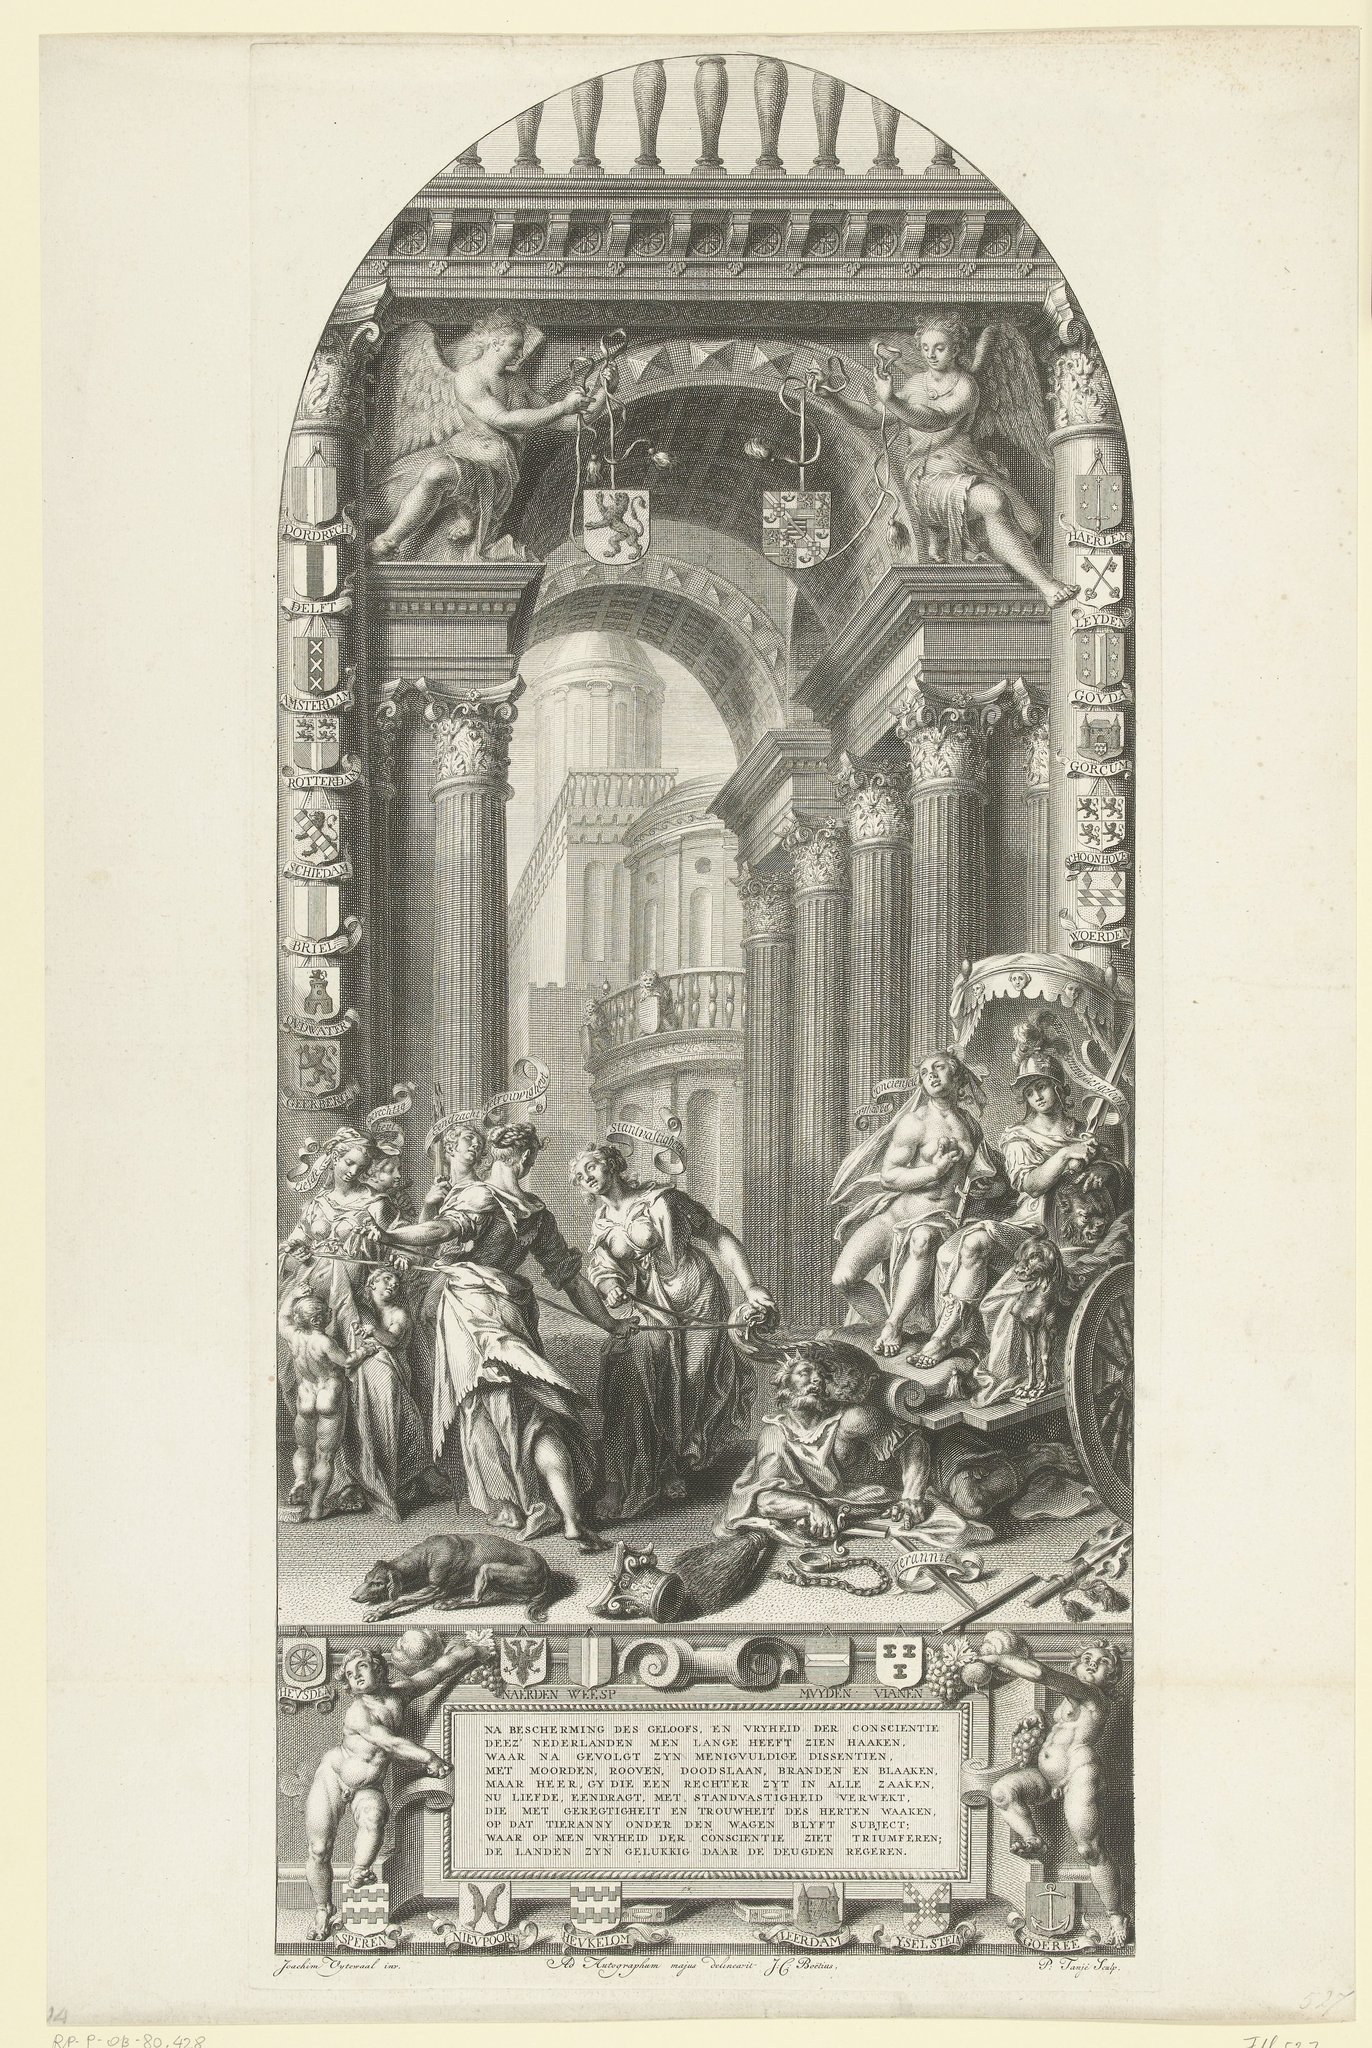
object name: historical object representation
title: Glasraam 1 in de Sint-Janskerk te Gouda: Vrijheid van Geweten triomfeert over de Tirannie, ca. 1568-1595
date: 1738-1754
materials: paper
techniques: engraving, etching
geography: amsterdam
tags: triumph of the church (or religion), 'sapientia' and the seven virtues, i.e. the three theological and the four cardinal virtues, dictatorial government, tyranny; 'tirannide' (ripa)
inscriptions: collector's mark: Lugt 2228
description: Het glasraam in de Sint-Janskerk te Gouda met de voorstelling: Vrijheid van Geweten triomfeert over de Tirannie. Op een strijdwagen zitten de Nederlandse overheid in de gedaante van Minerva en Vrijheid van Geweten. Zij overrijden de Tirannie. De strijdwagen wordt getrokken door de personificaties van Standvastigheid, Liefde, Eendracht, Rechtvaardigheid en Trouw. De voorstelling wordt omringd door de wapens van steden in het Zuiderkwartier van de Staten van Holland. Deze steden zijn de schenkers van het glasraam aan de stad Gouda. Onderaan een cartouche met een tienregelige tekst in het Nederlands. Glasraam door glazenier Adriaan Gerritsz. de Vrije naar ontwerp van Wtewael uit 1595-1596 en geplaatst in 1597.